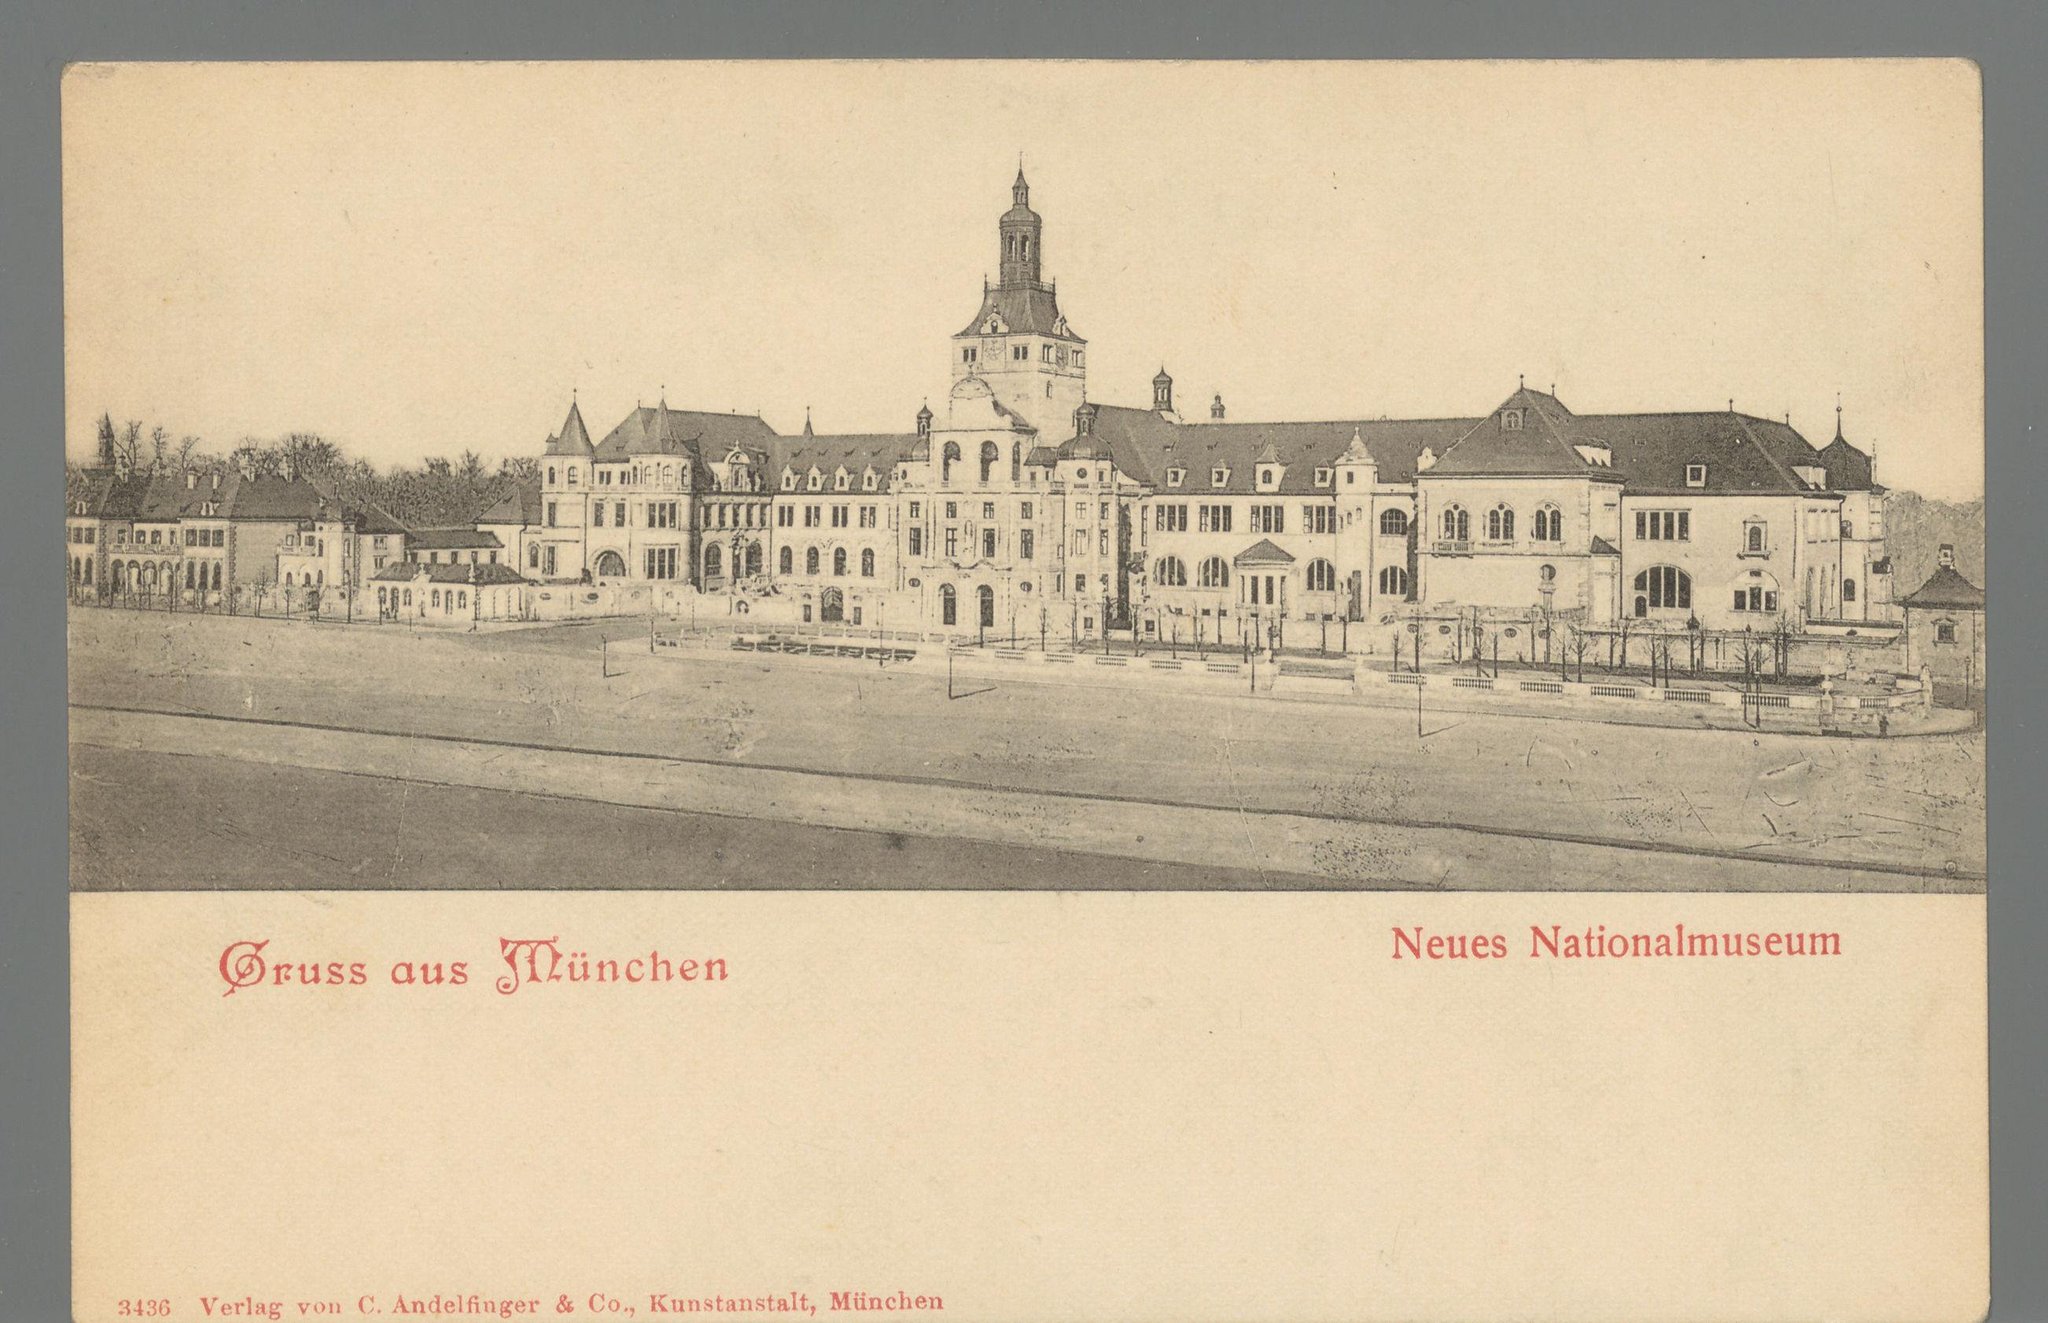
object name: photomechanical print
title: Gruss aus München. Neues Nationalmuseum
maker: Anonymous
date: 1885-1905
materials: cardboard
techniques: photograph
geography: munich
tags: permanent exhibition, museum